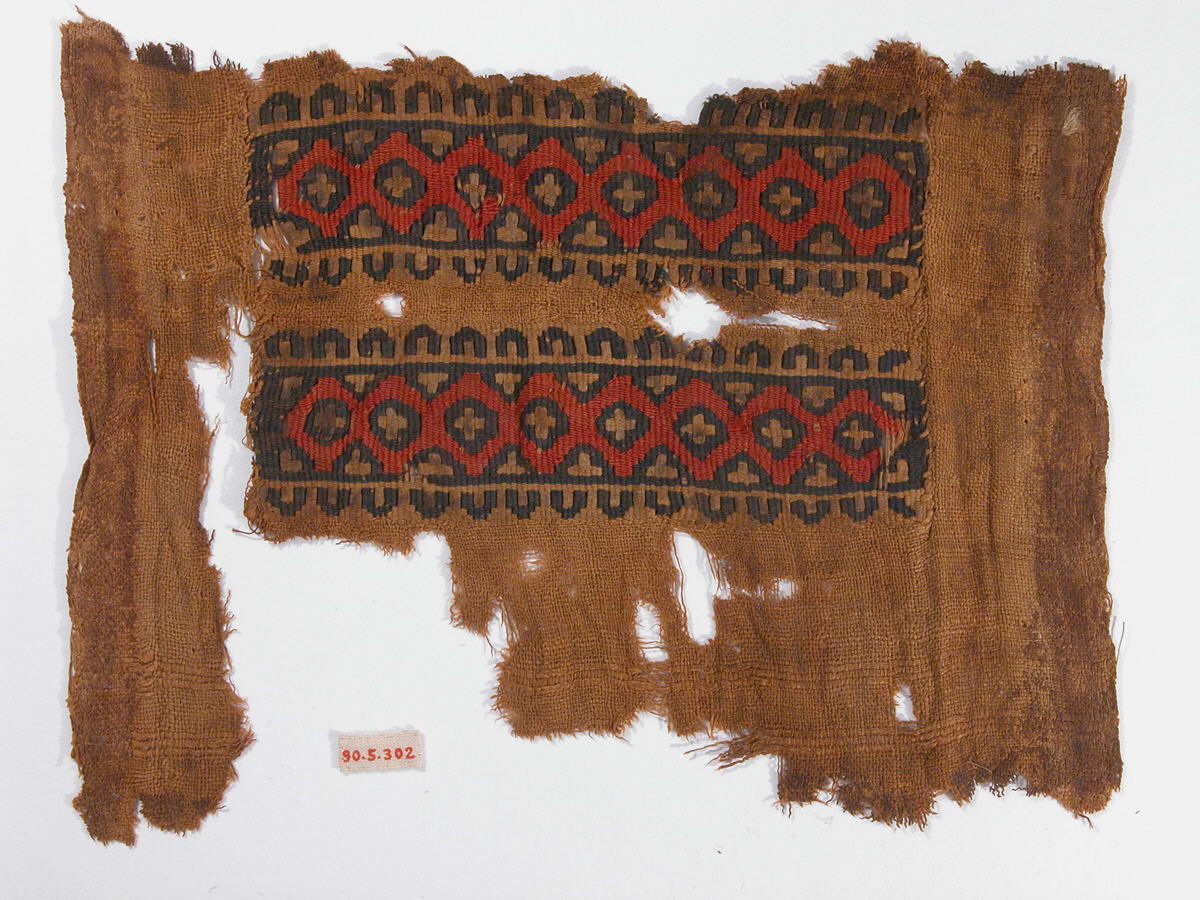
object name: textile fragment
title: Fragment of a Sleeve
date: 301-500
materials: linen, wool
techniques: weave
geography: egypt